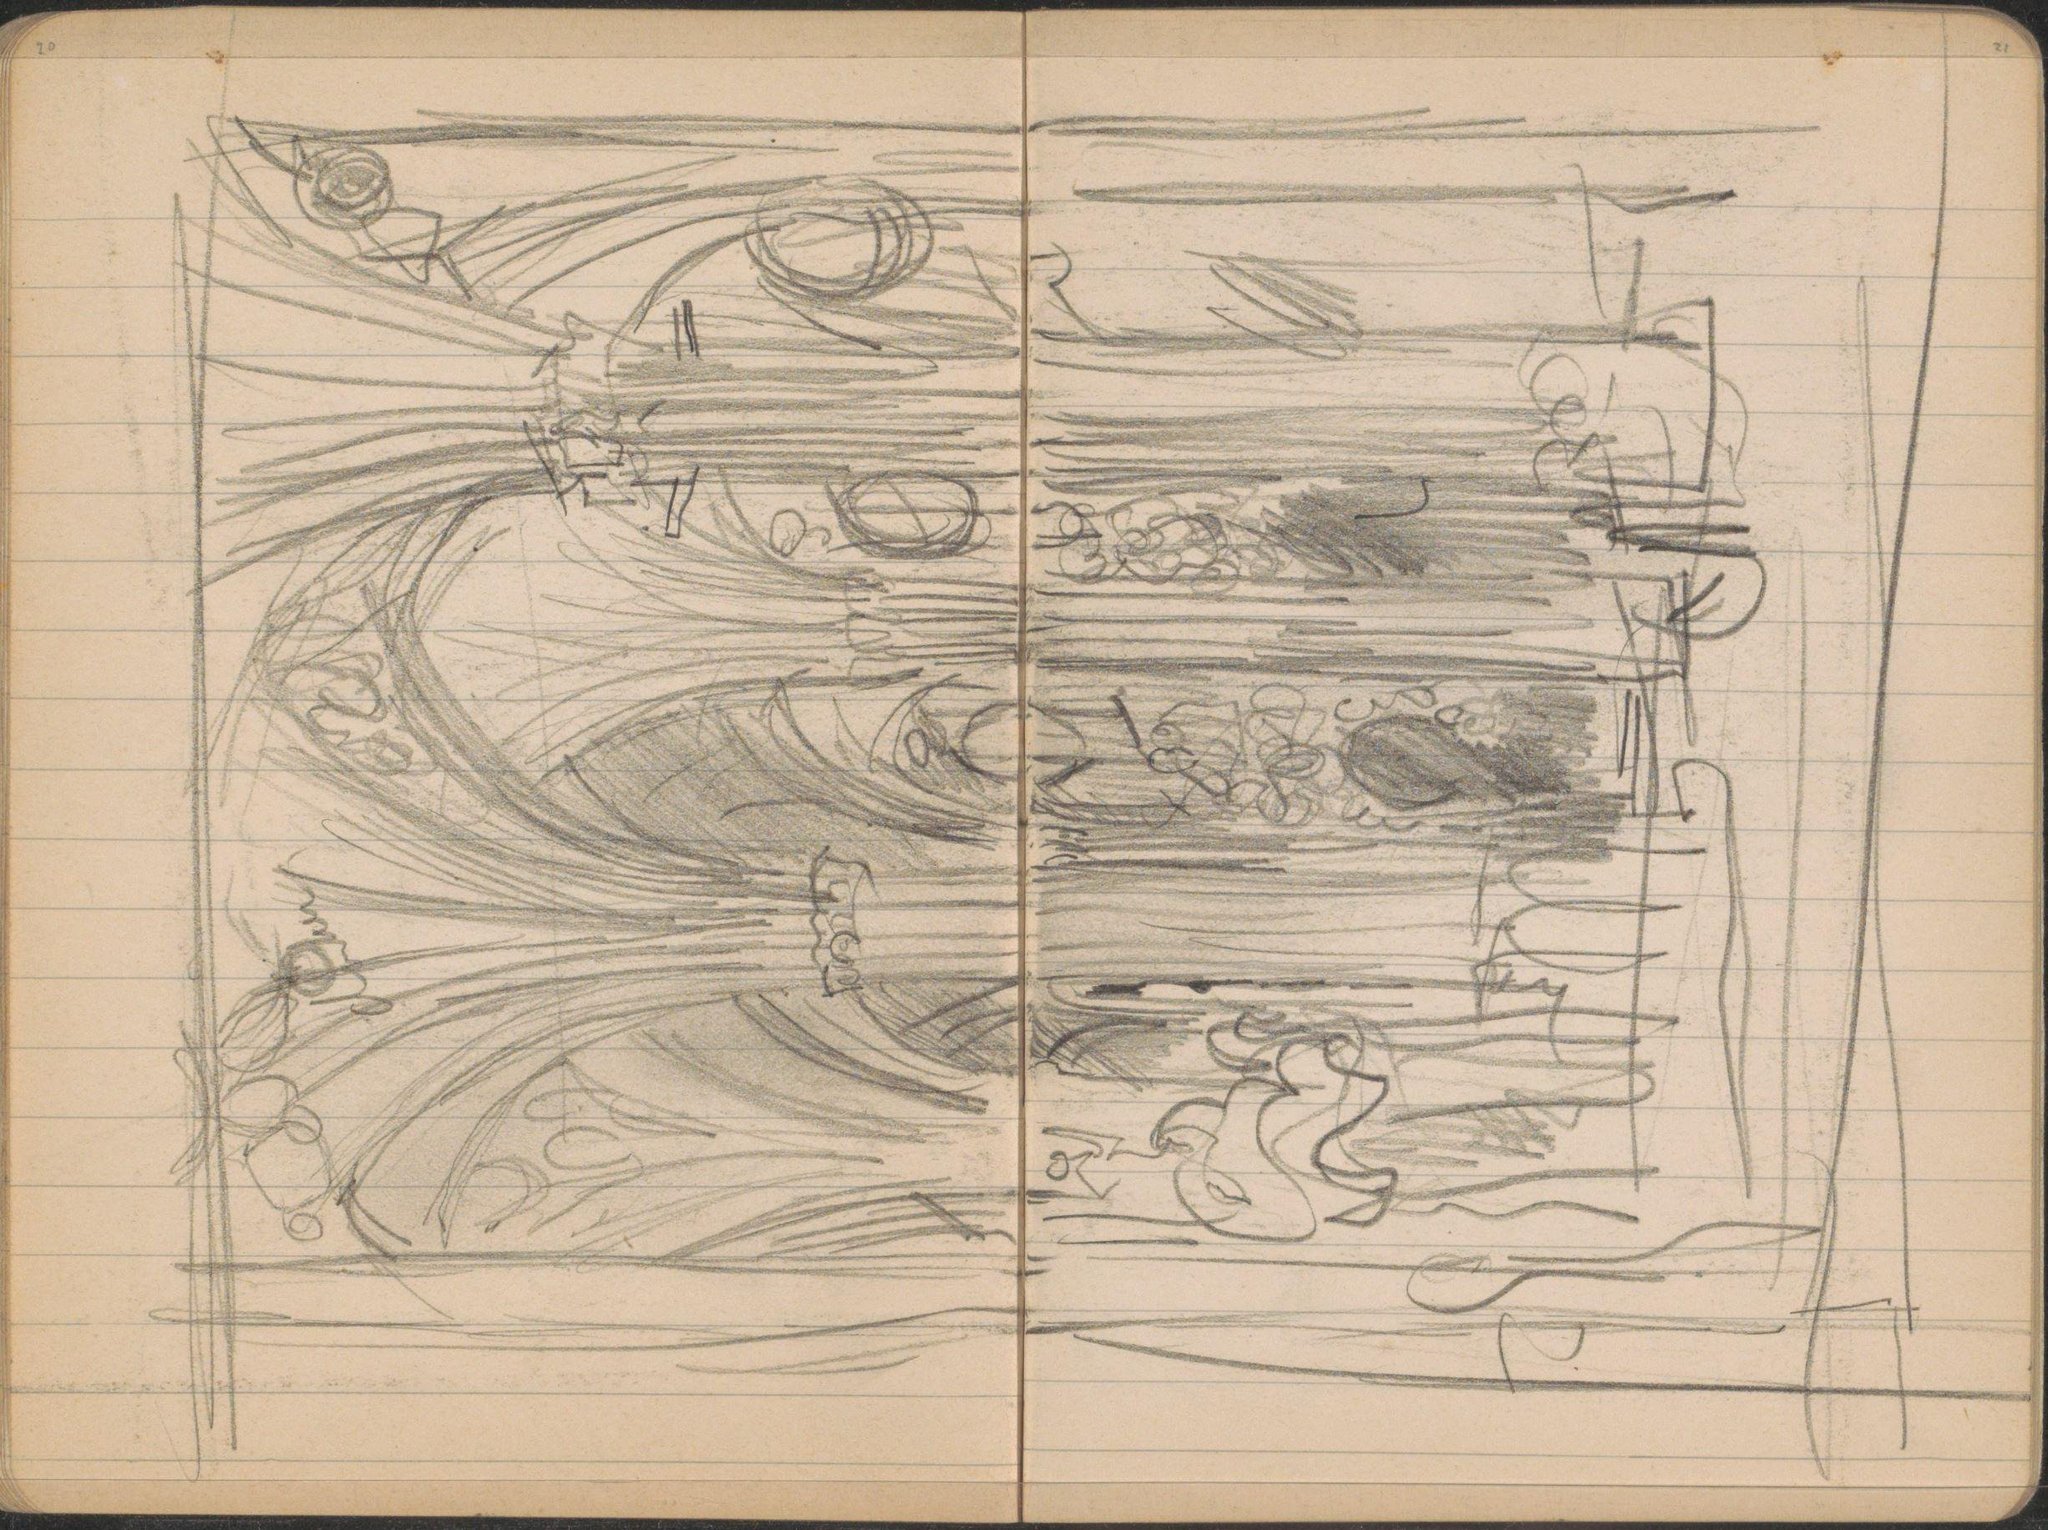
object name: sketchbook leaf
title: Interieur van de La Seo kathedraal in Zaragoza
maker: marius bauer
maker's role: draughtsman, print maker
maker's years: 1867-1932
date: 1902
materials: pencil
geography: zaragoza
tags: interior of church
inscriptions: kleurnotitie, handgeschreven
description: Pagina 20 en 21 uit een schetsboek met 50 bladen.